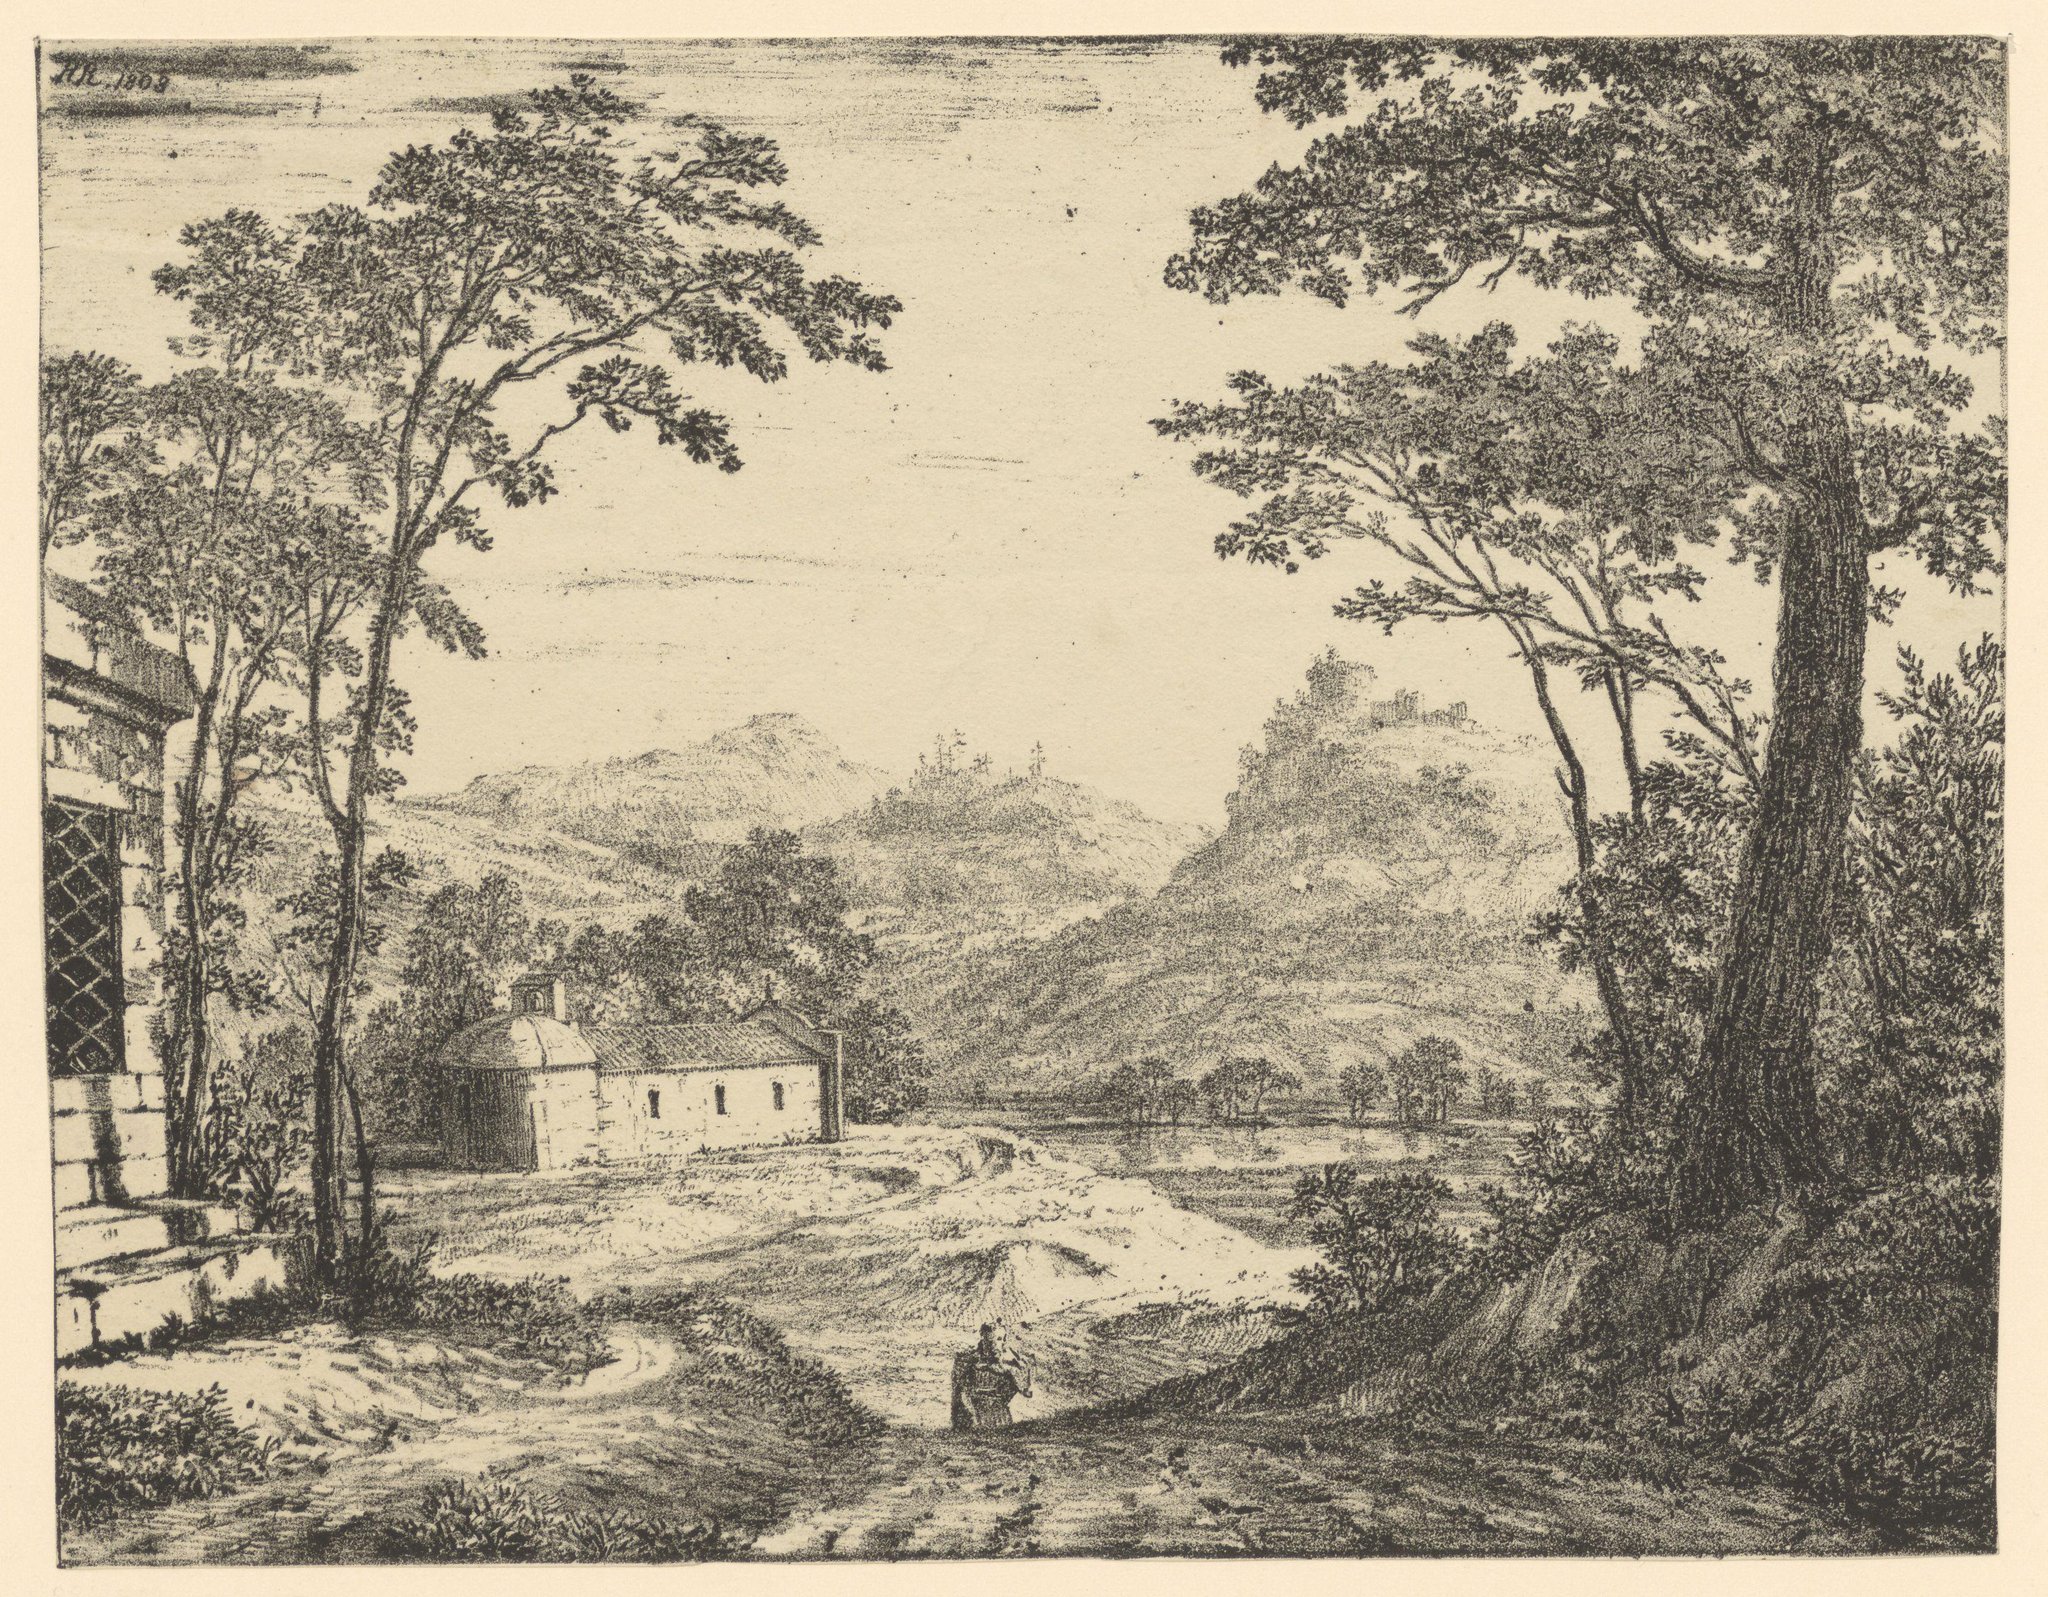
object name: print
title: Berglandschap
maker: gottlob heinrich von rapp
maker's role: print maker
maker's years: 1761-1832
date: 1803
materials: paper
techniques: lithograph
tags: mountains (+ landscape with figures, staffage)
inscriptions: collector's mark: Lugt 2228